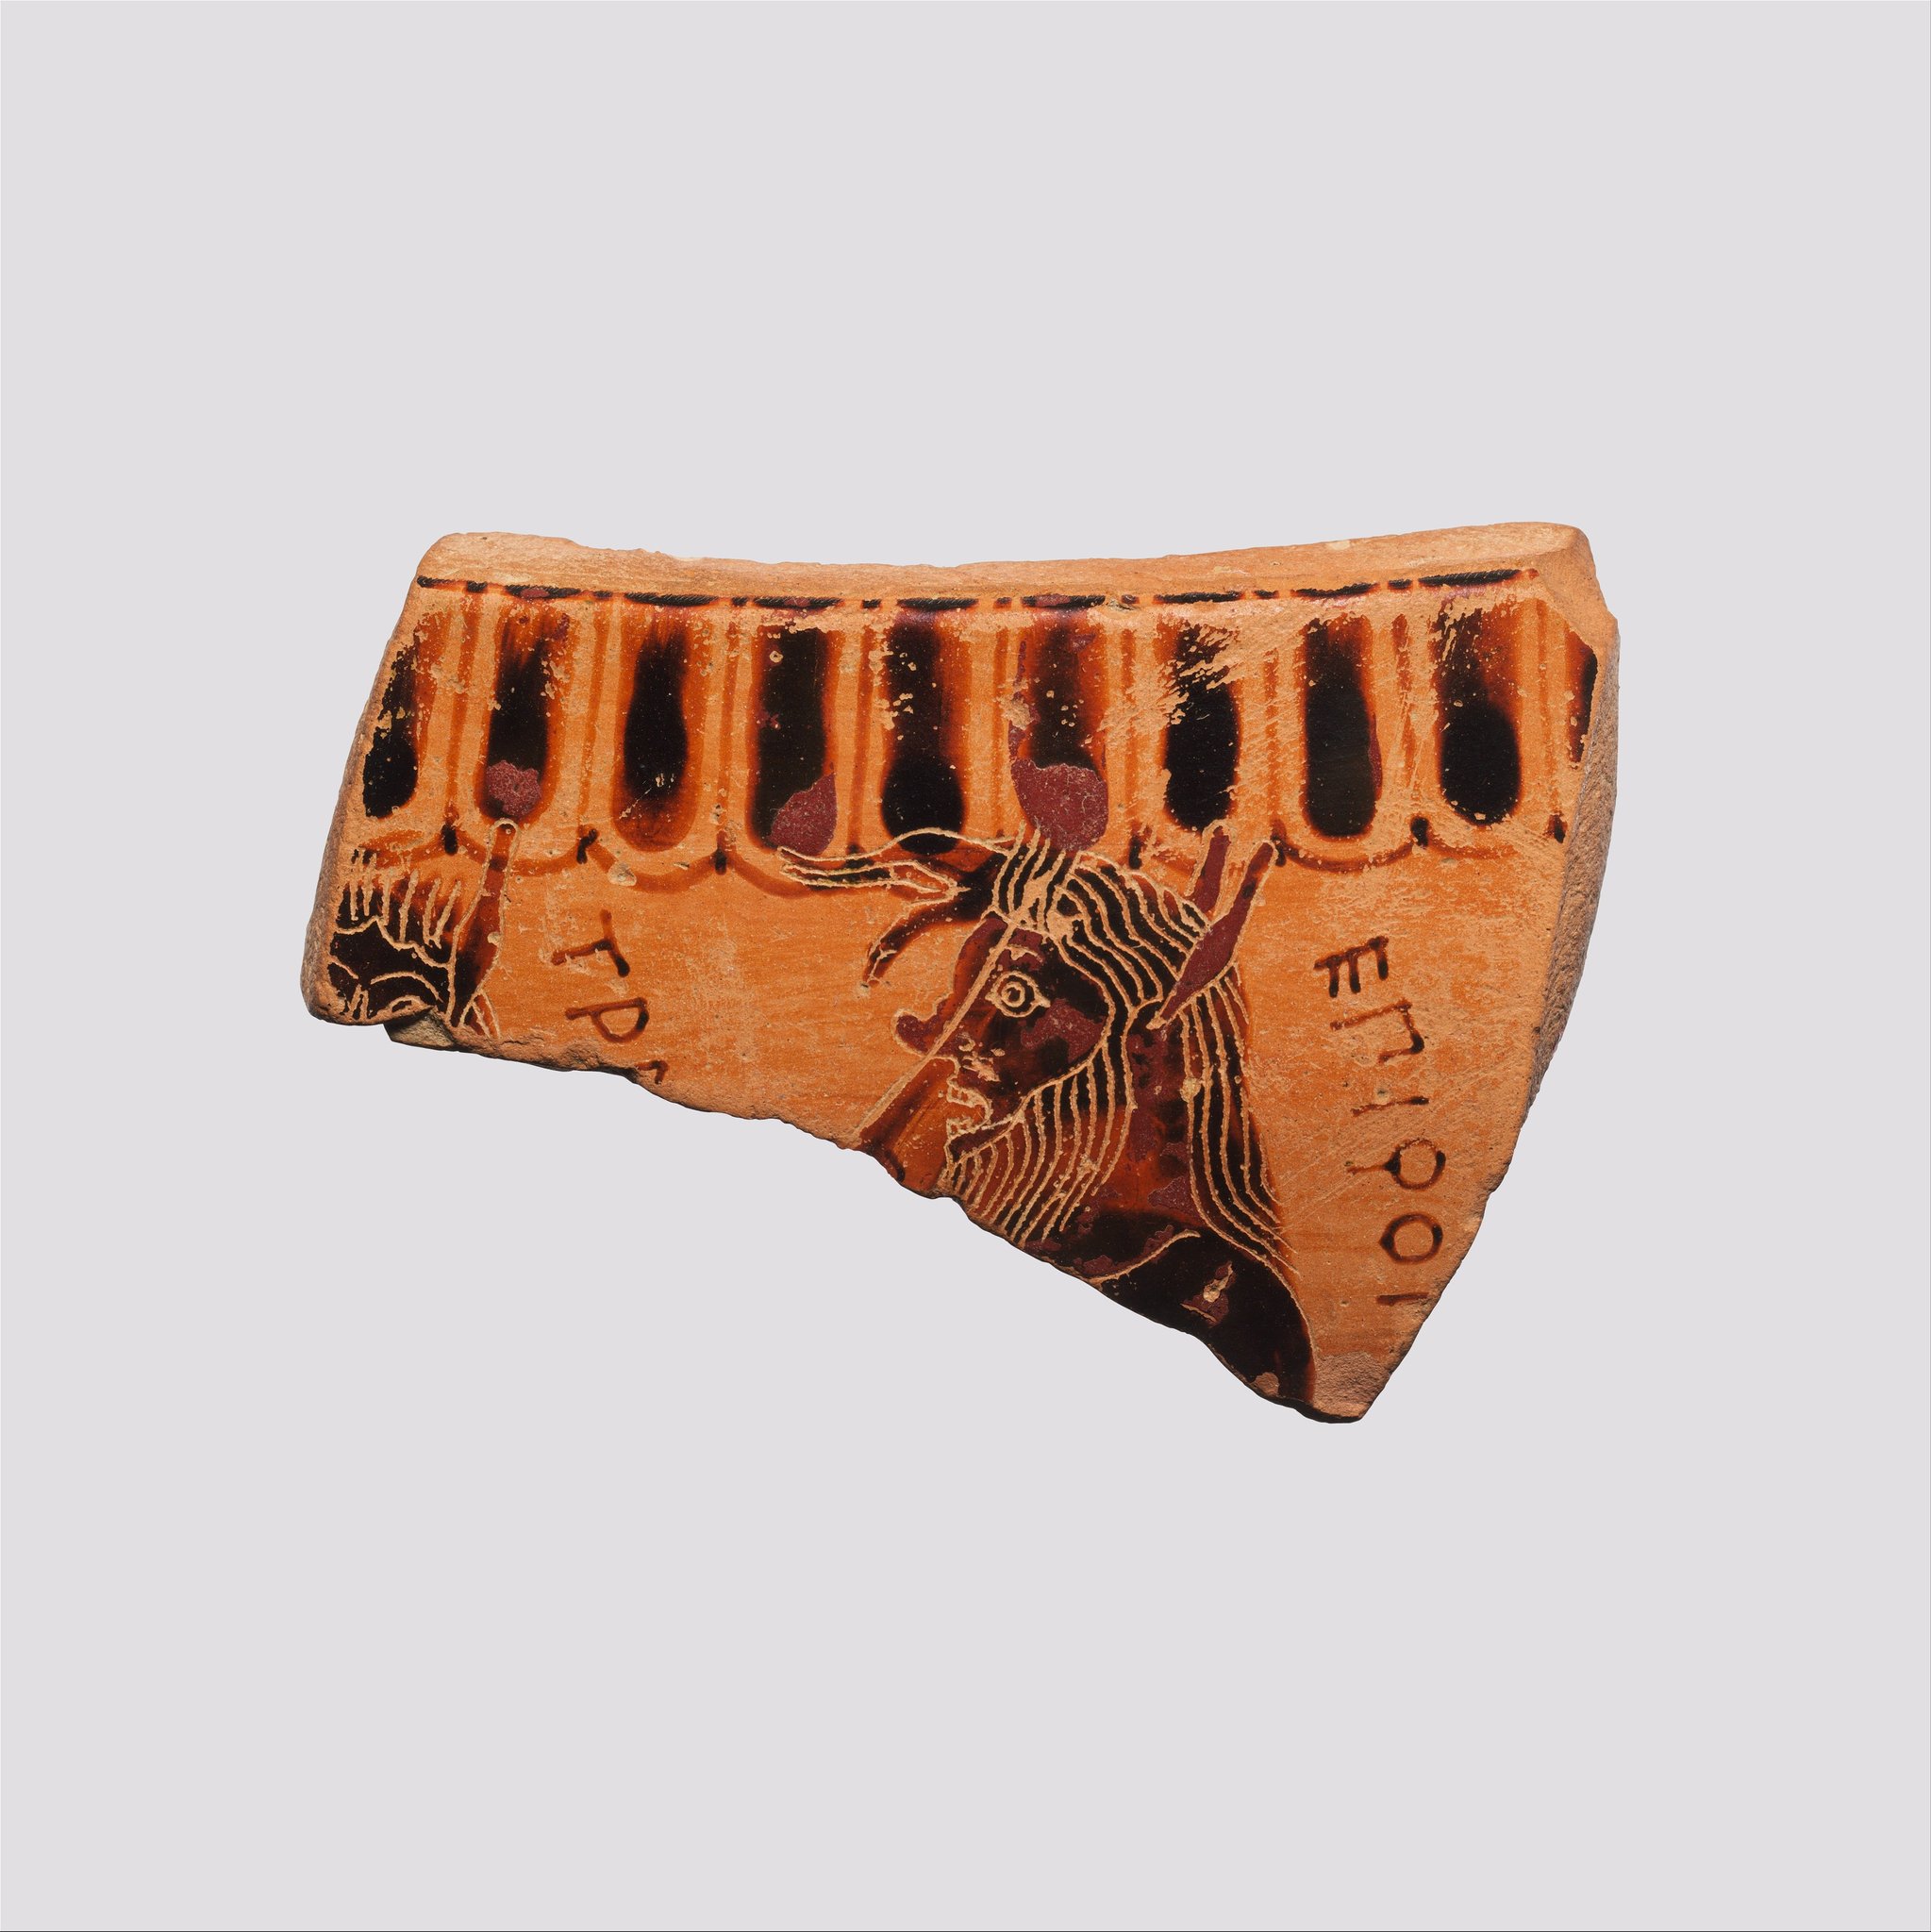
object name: krater or dinos fragment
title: Fragment of a terracotta krater or dinos (bowl for mixing wine and water)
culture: greek, attic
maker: sophilos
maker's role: artist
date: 570 BCE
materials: terracotta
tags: satyrs